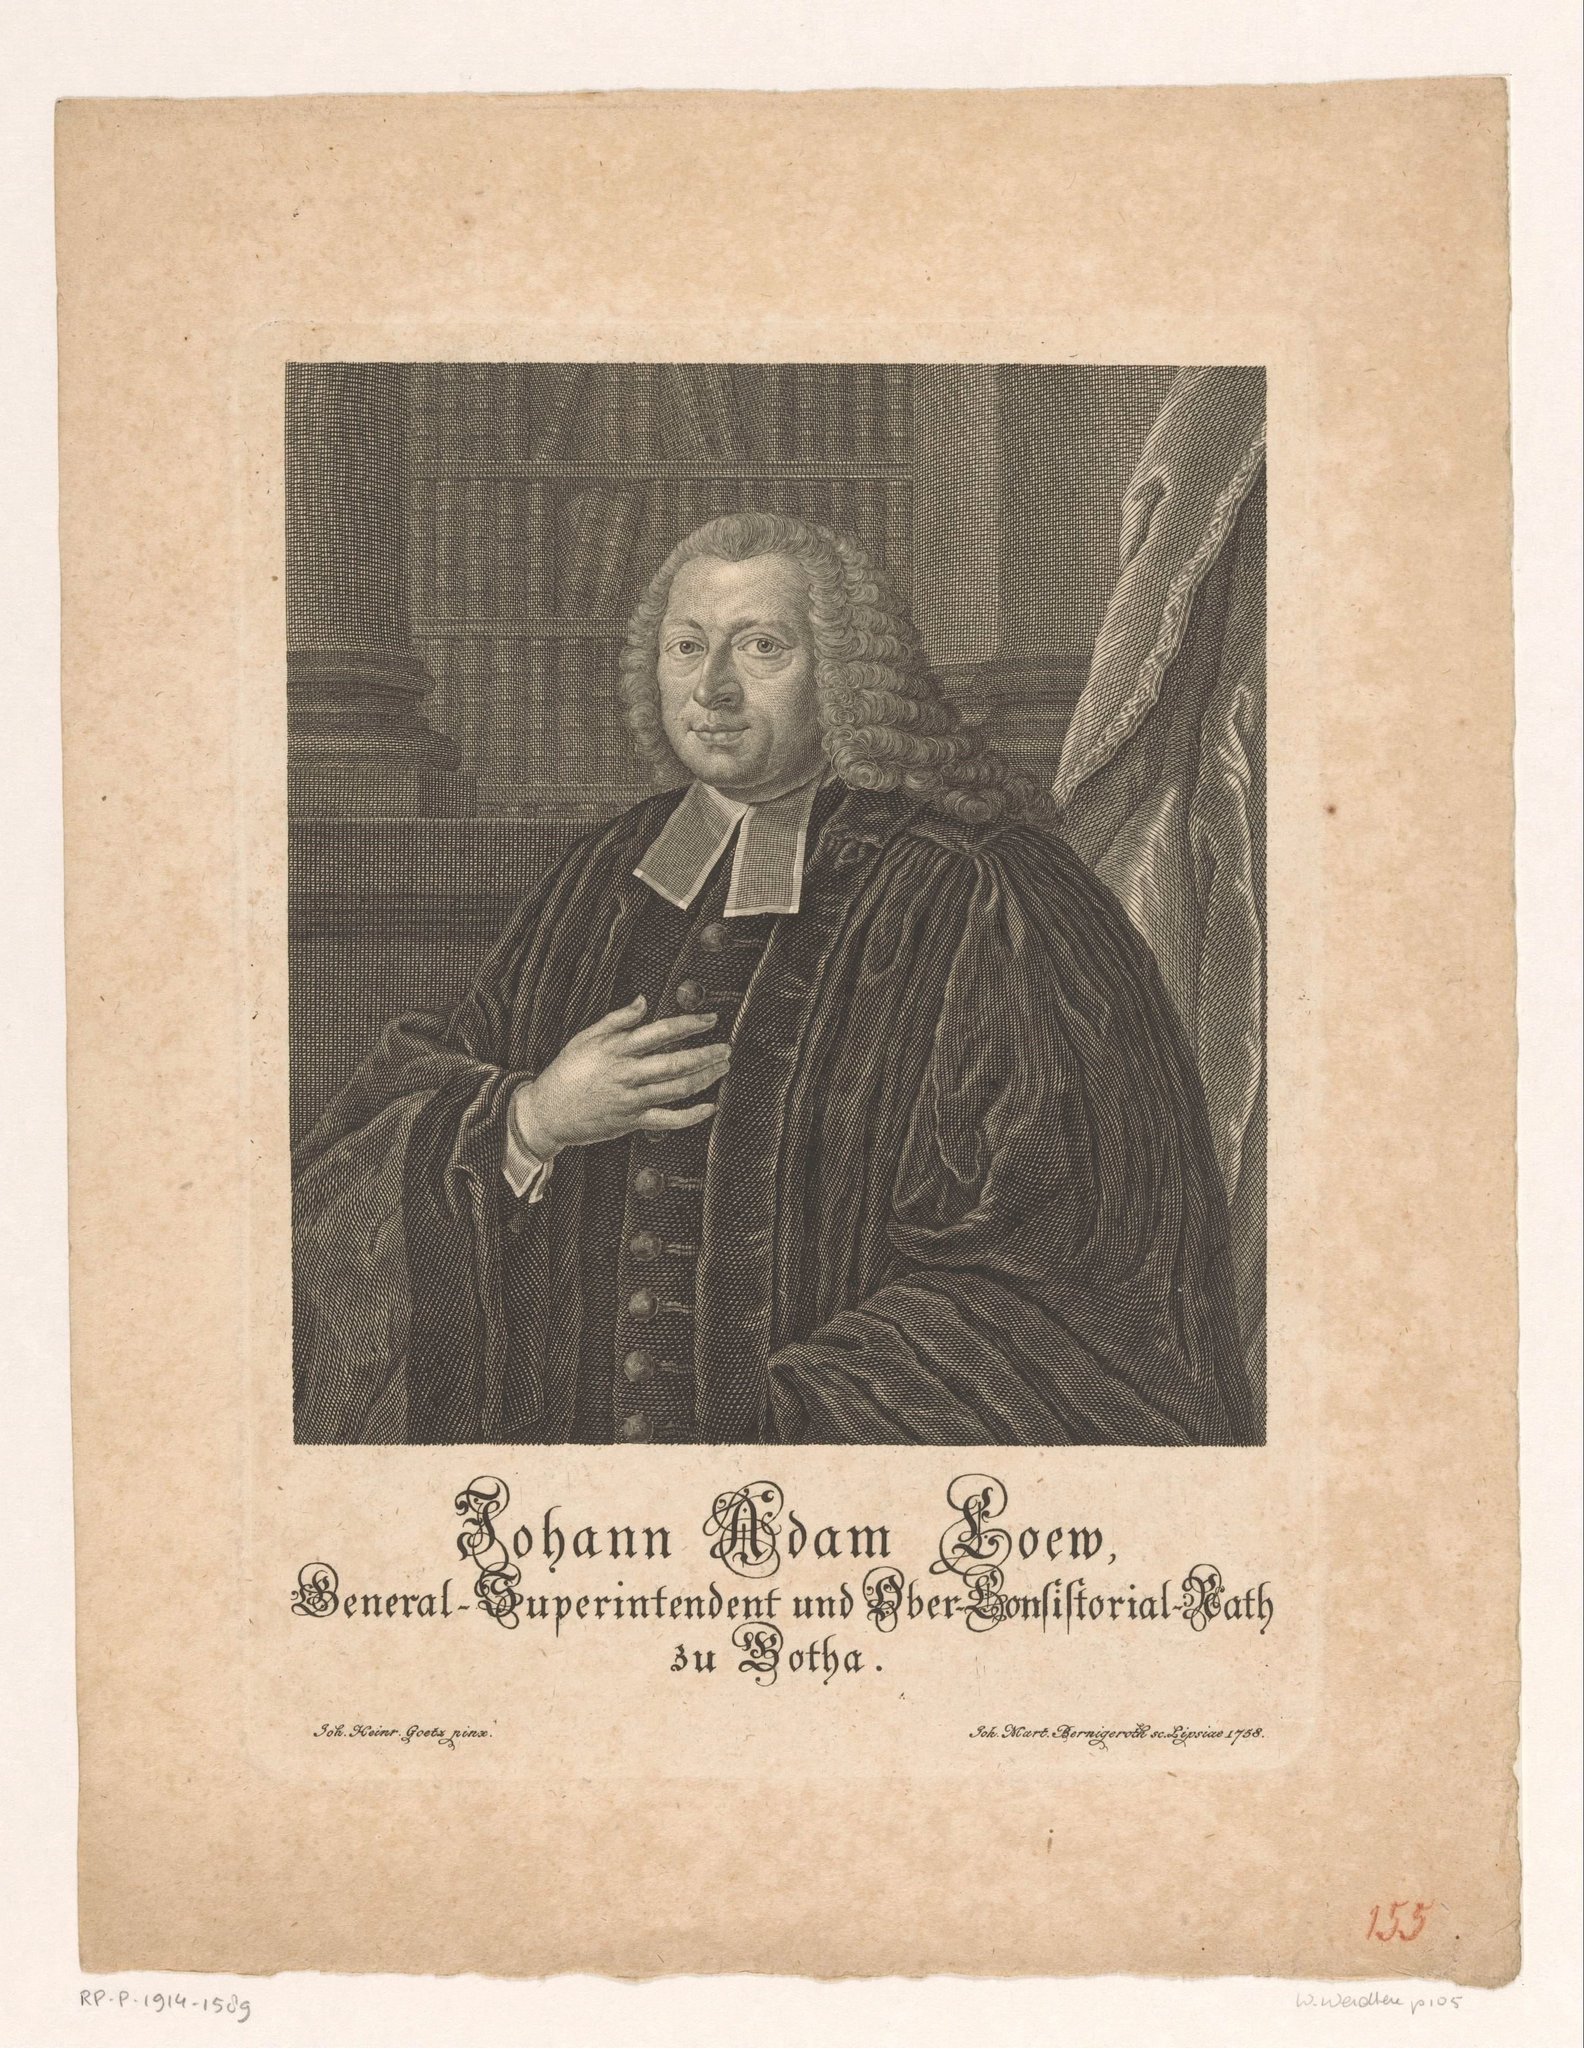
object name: print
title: Portret van Johann Adam Löw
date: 1758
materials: paper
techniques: engraving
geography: leipzig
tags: bookshelves, historical persons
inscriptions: collector's mark: Lugt 2228